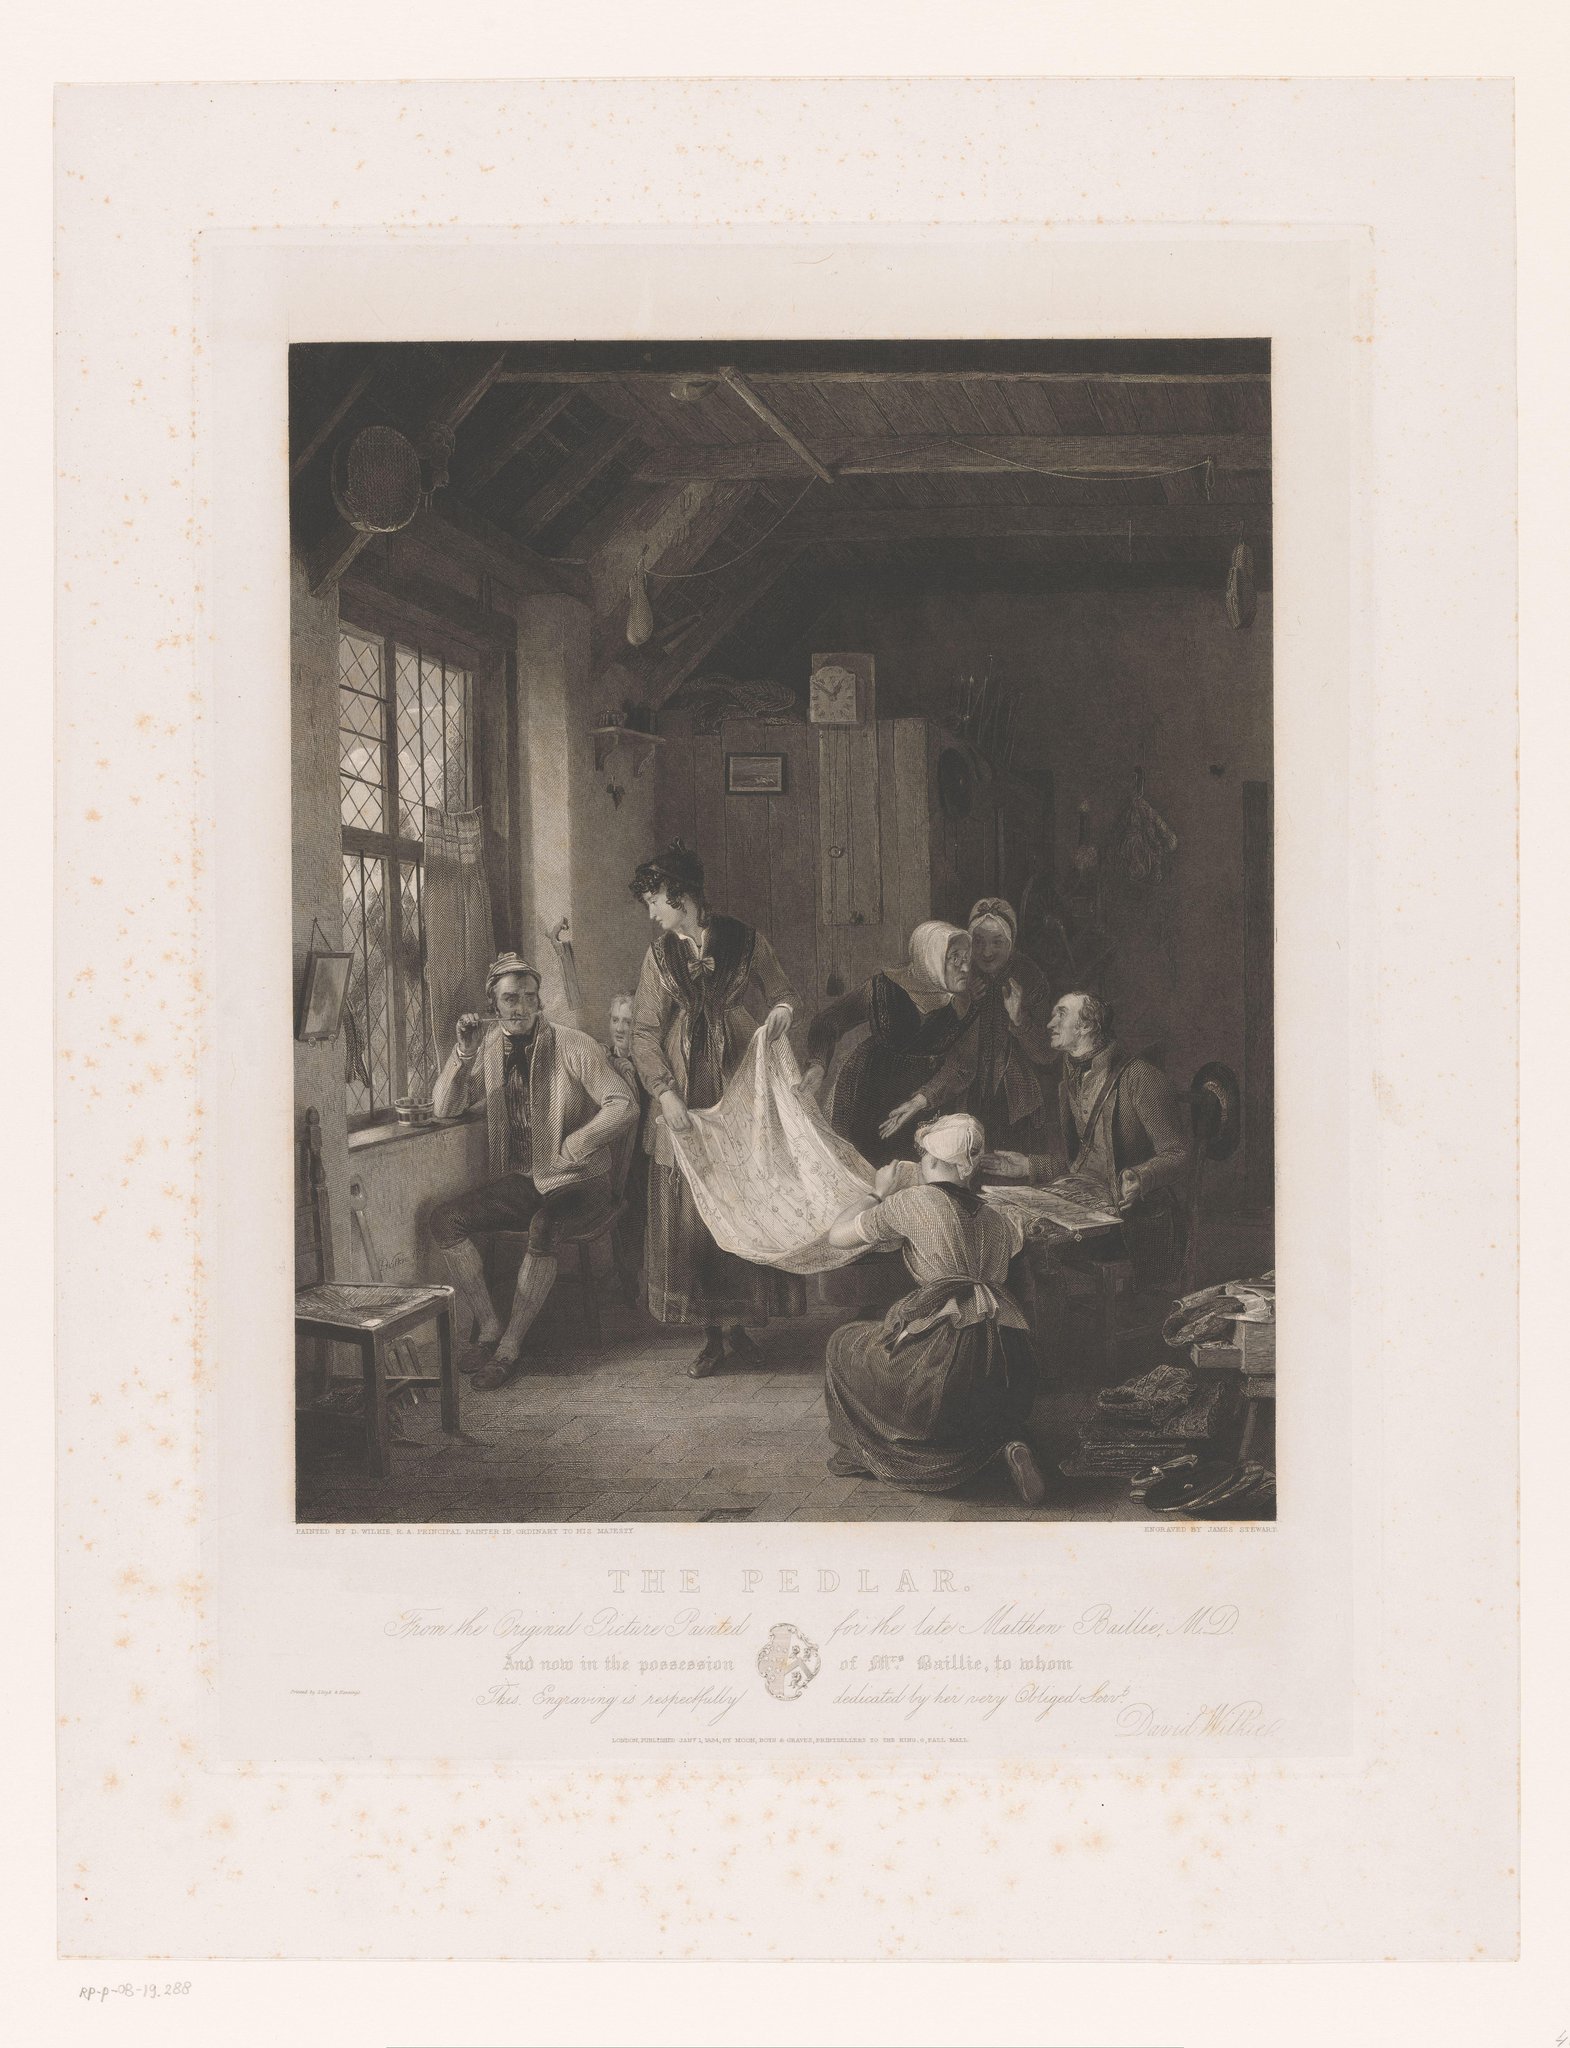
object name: print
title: The Pedlar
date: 1834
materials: paper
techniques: engraving, etching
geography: london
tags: pedlar, family life at home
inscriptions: collector's mark: Lugt 12